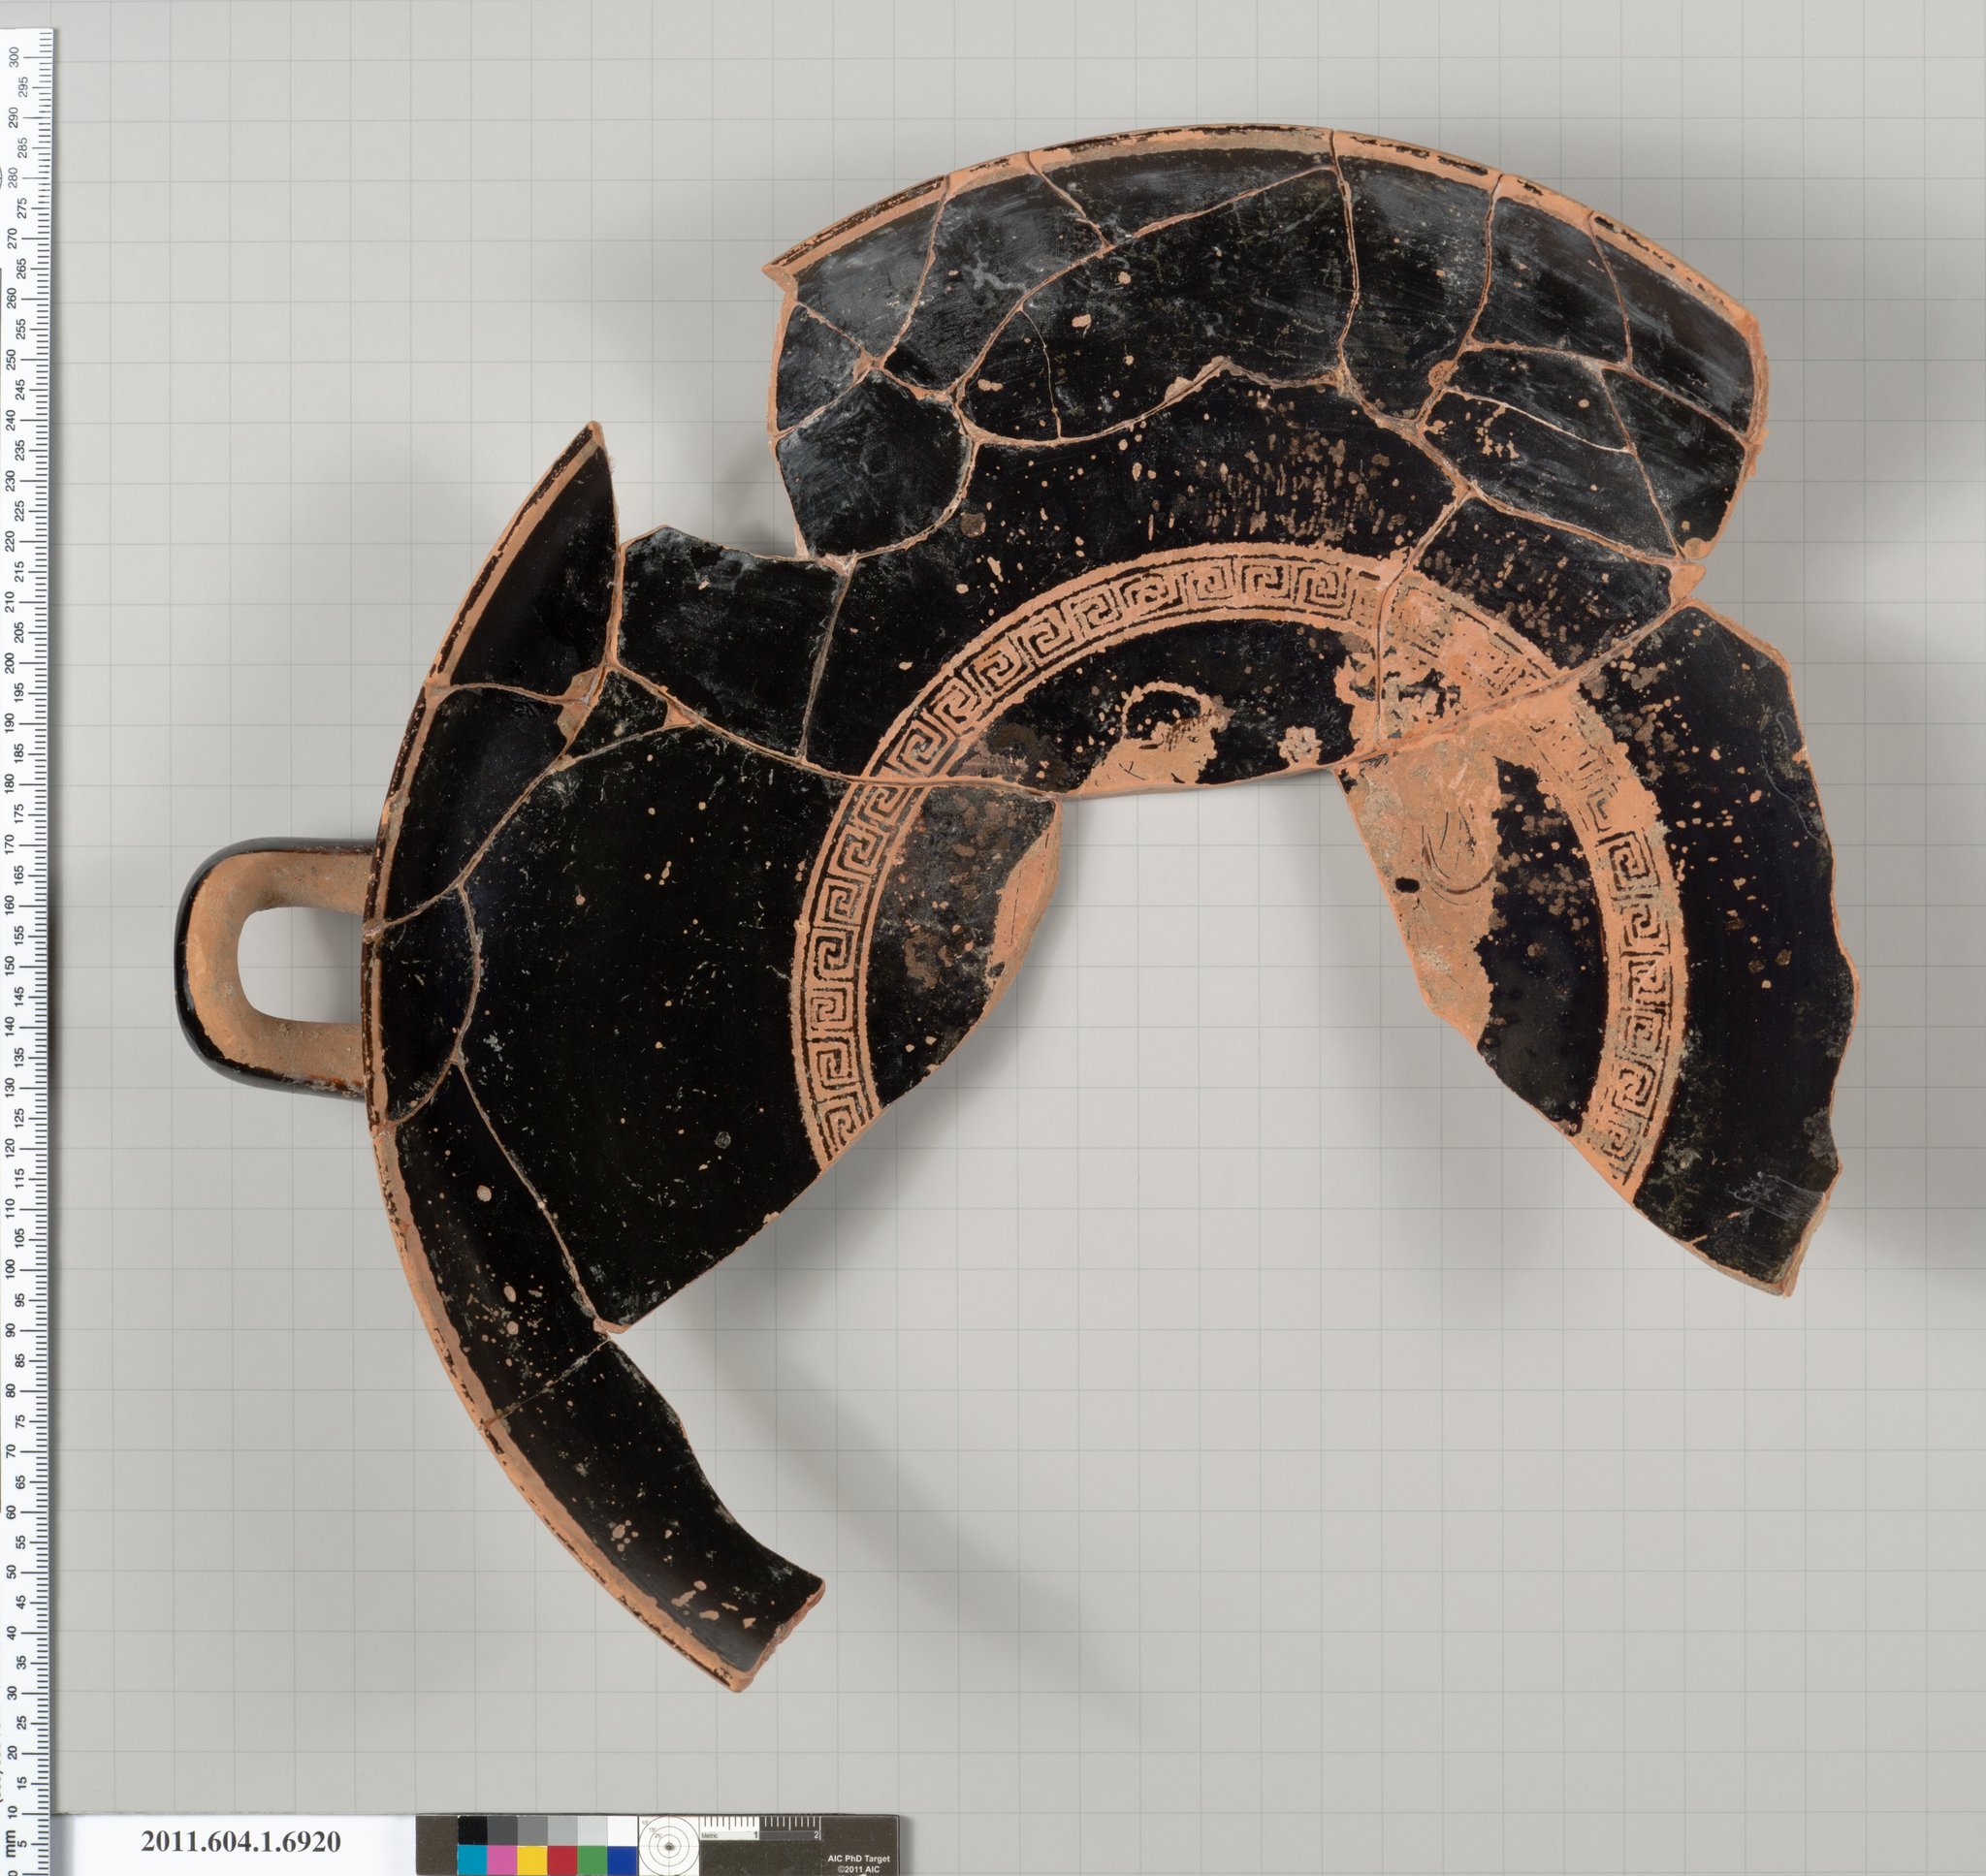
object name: kylix fragment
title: Terracotta fragment of a kylix (drinking cup)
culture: greek, attic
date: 490-470 BCE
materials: terracotta